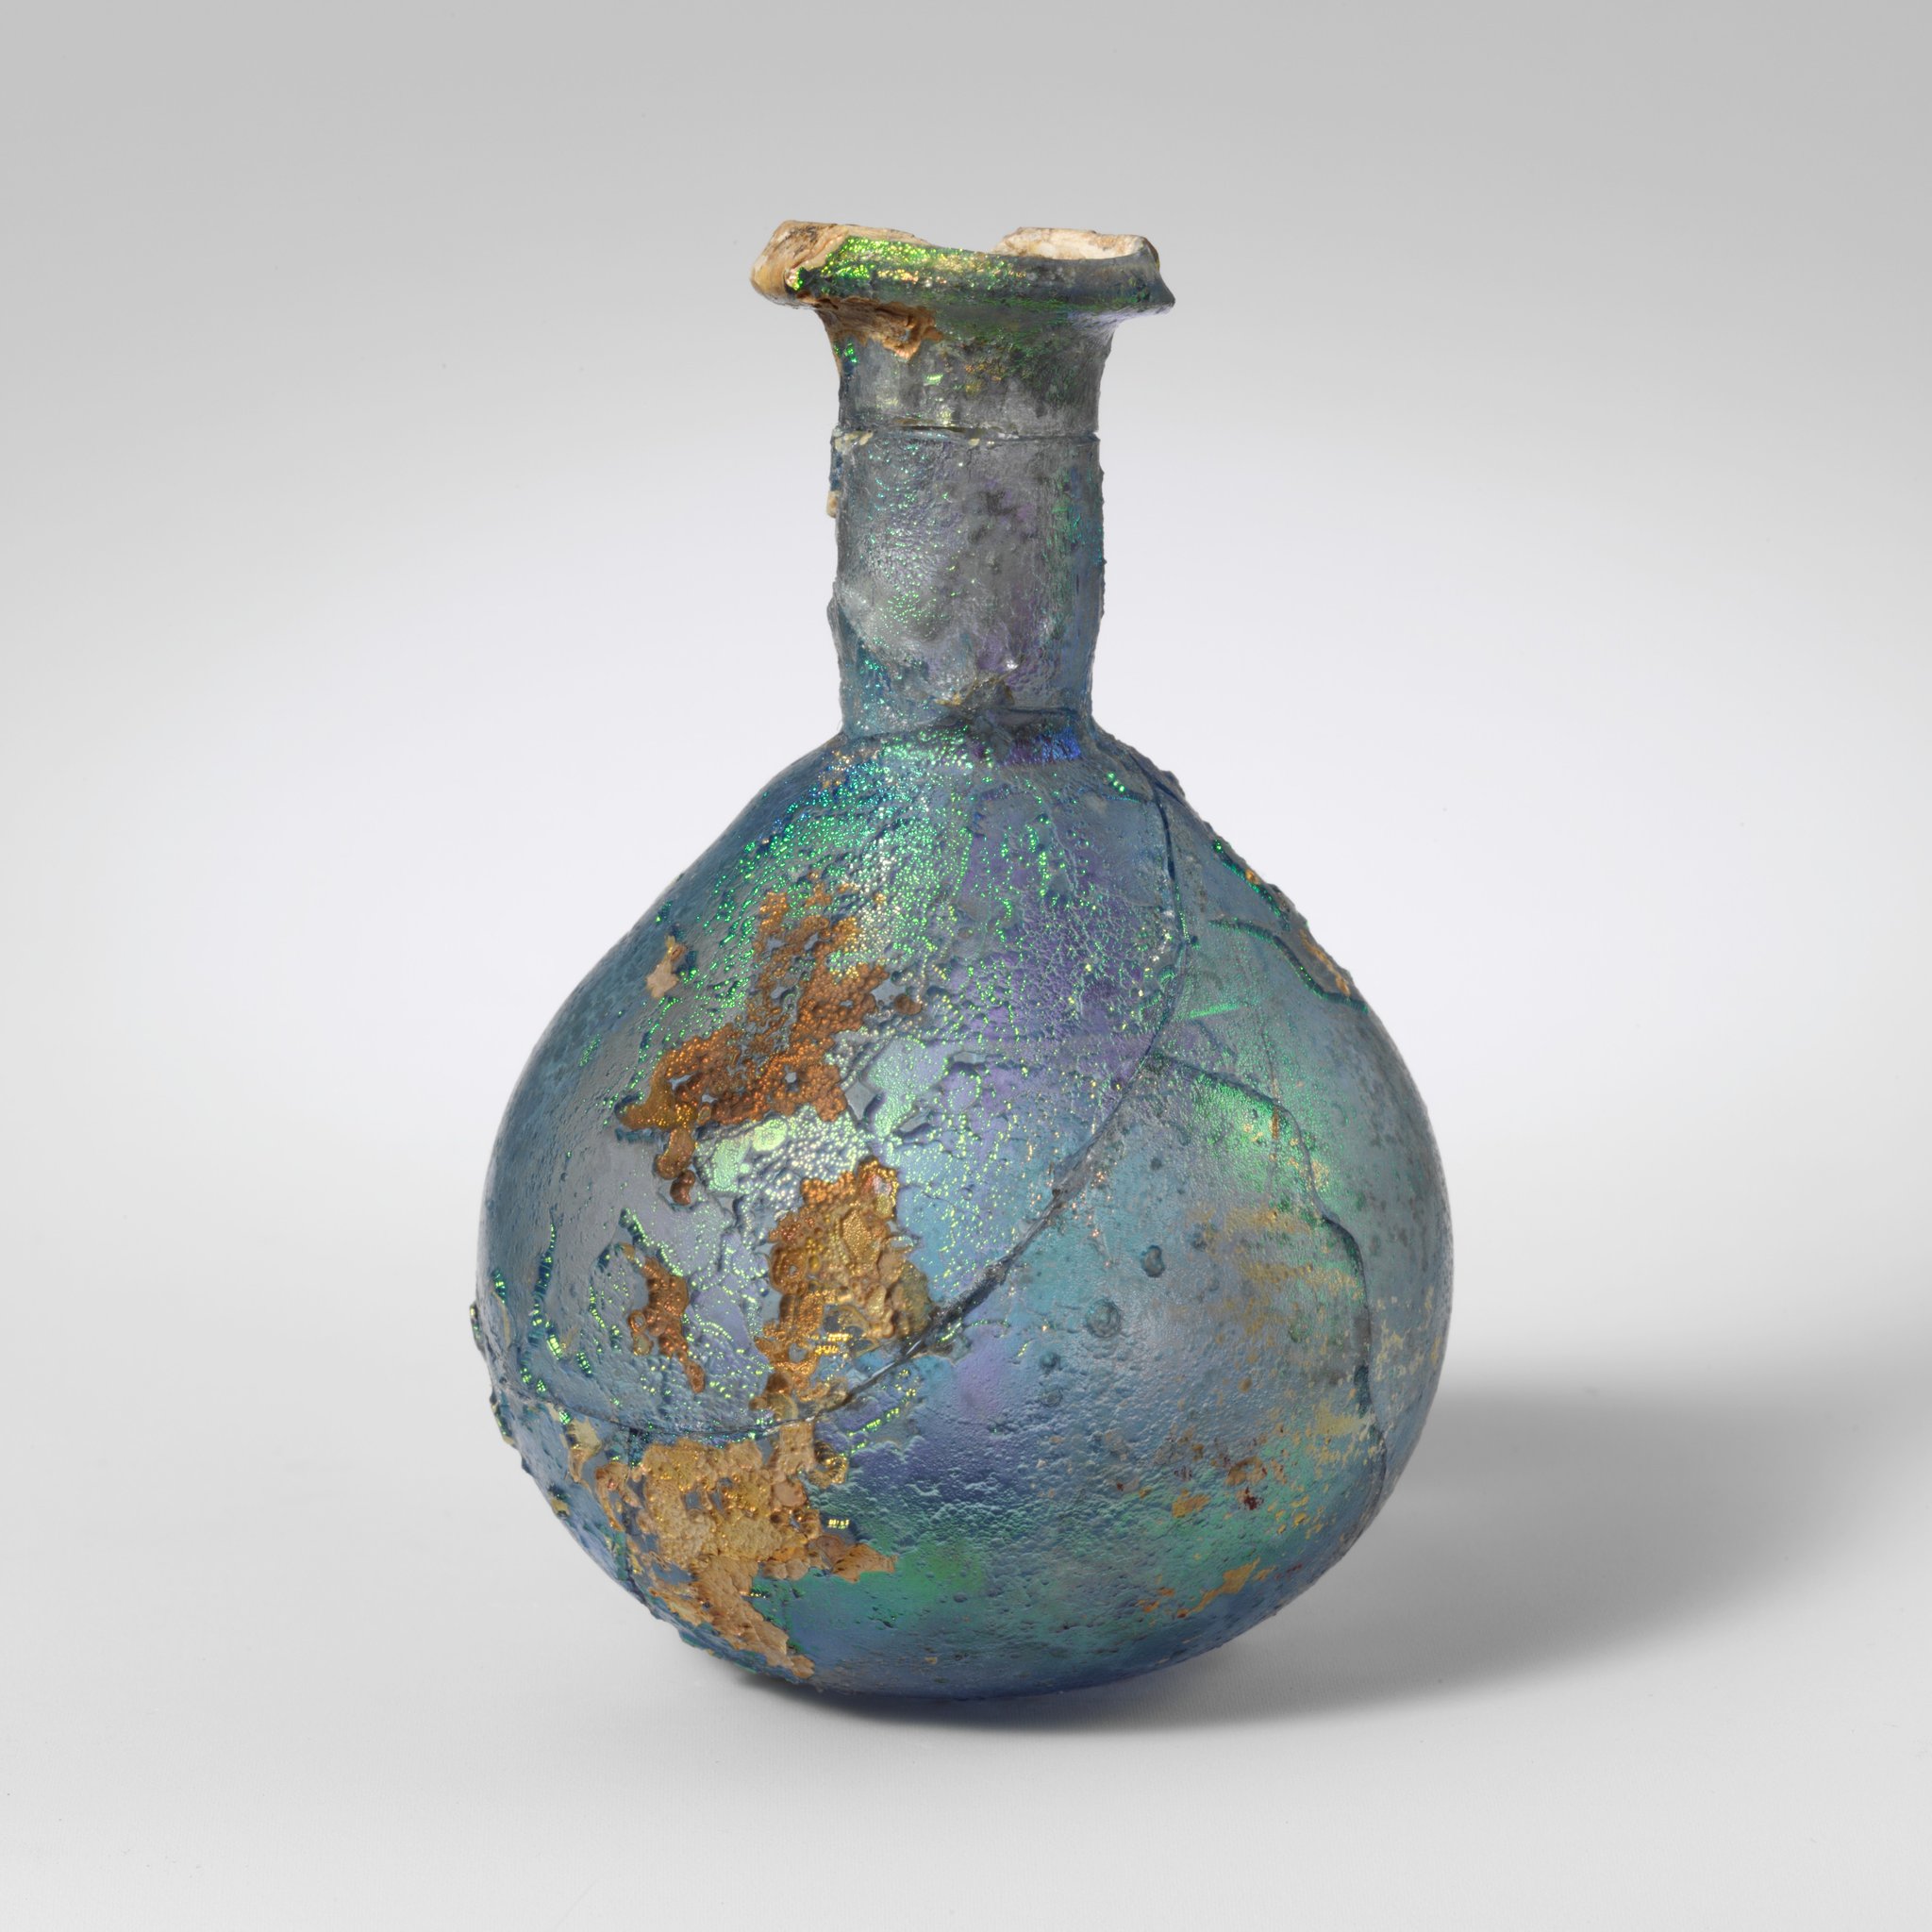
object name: perfume bottle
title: Glass perfume bottle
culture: roman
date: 1-100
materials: glass